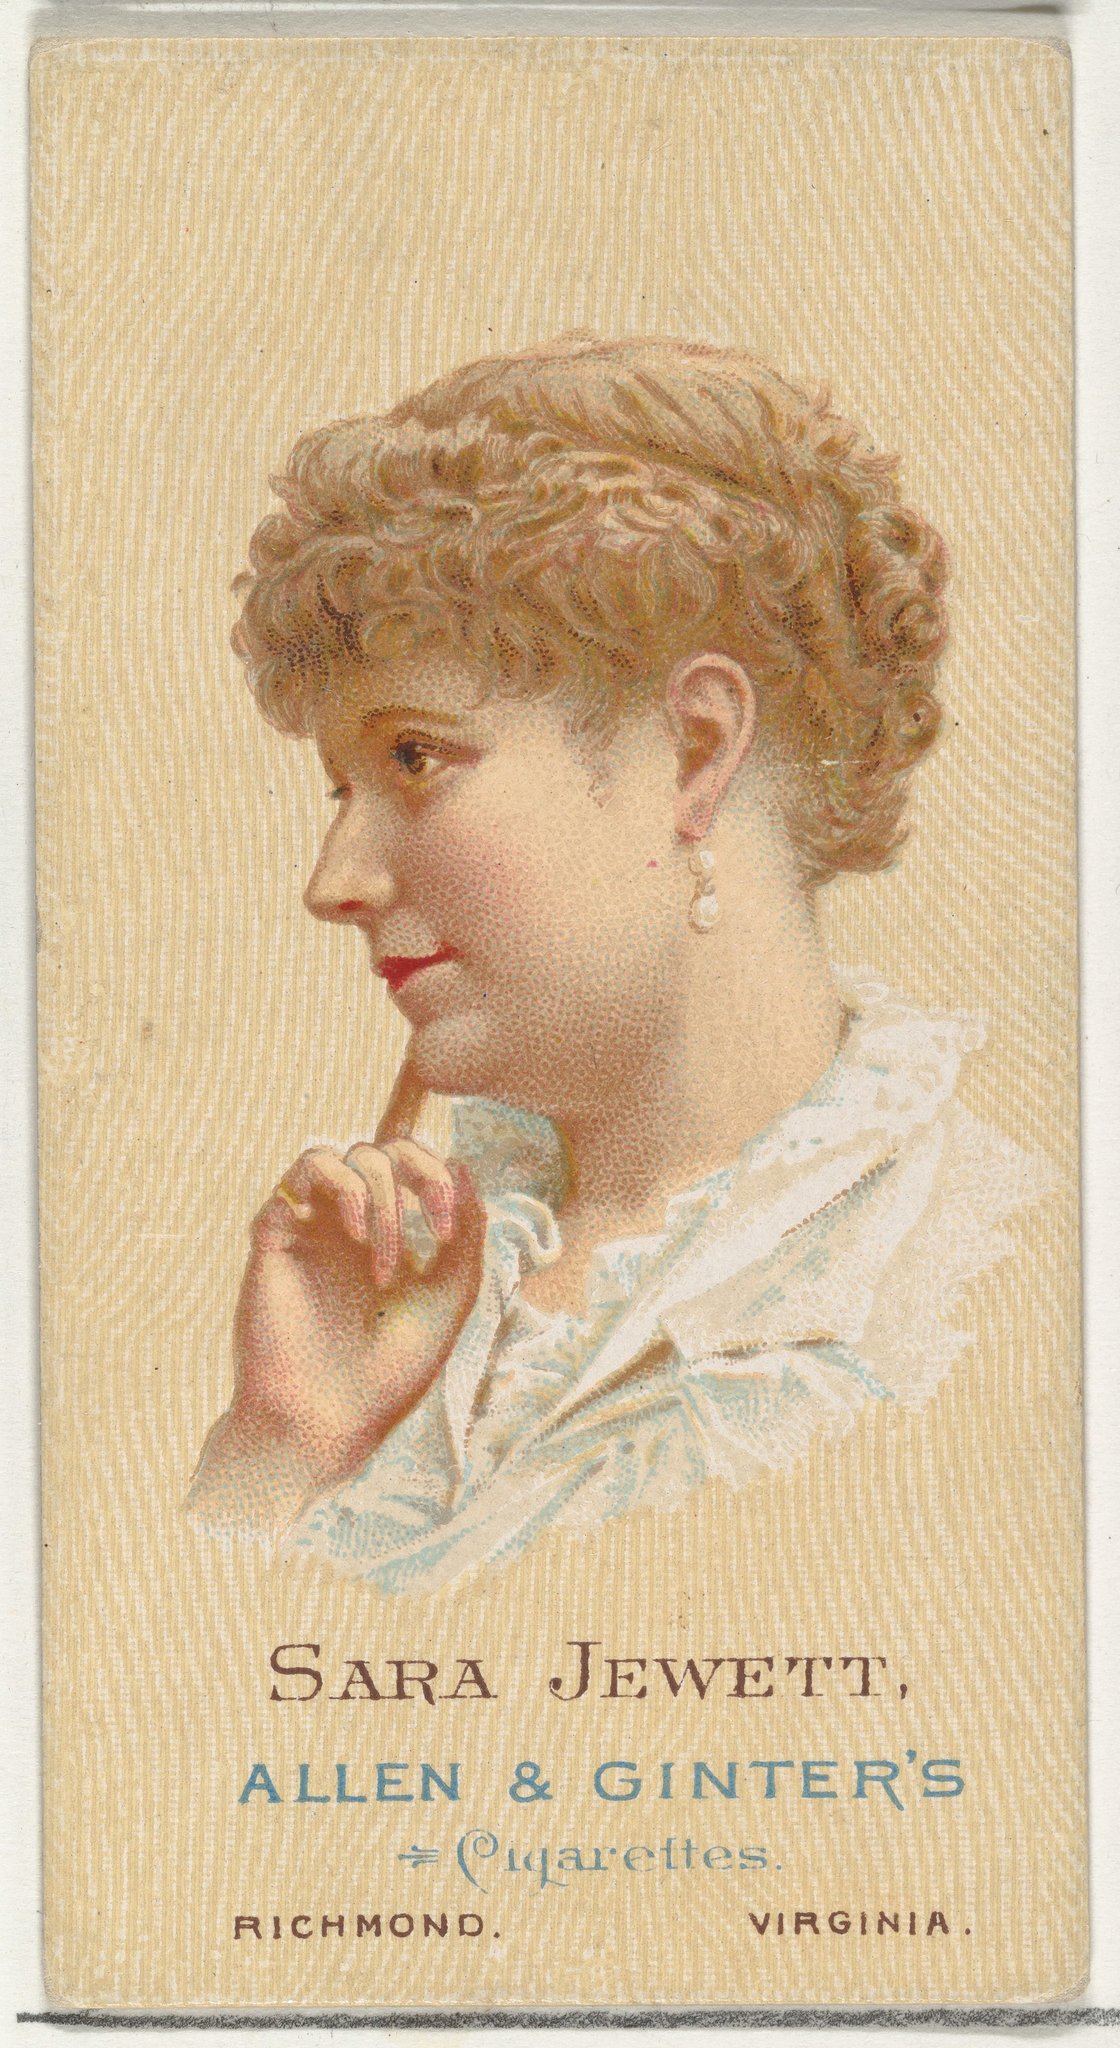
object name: print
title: Sara Jewett, from World's Beauties, Series 2 (N27) for Allen & Ginter Cigarettes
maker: allen & ginter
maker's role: publisher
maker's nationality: american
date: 1888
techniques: color lithograph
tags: women